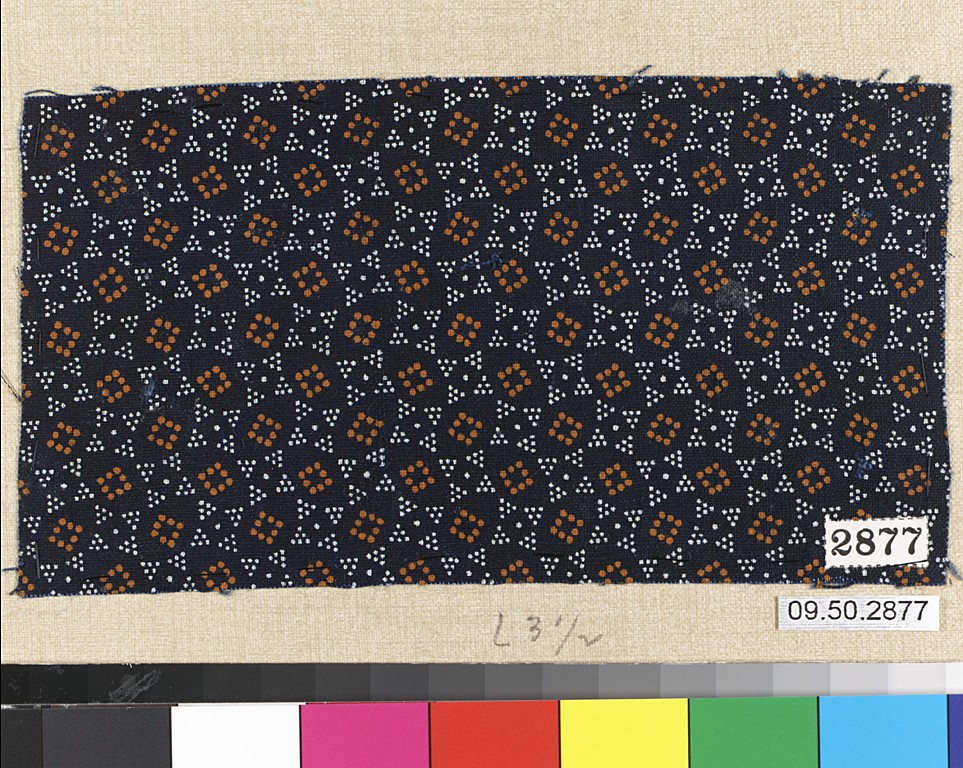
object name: piece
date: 1801-1900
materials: cotton